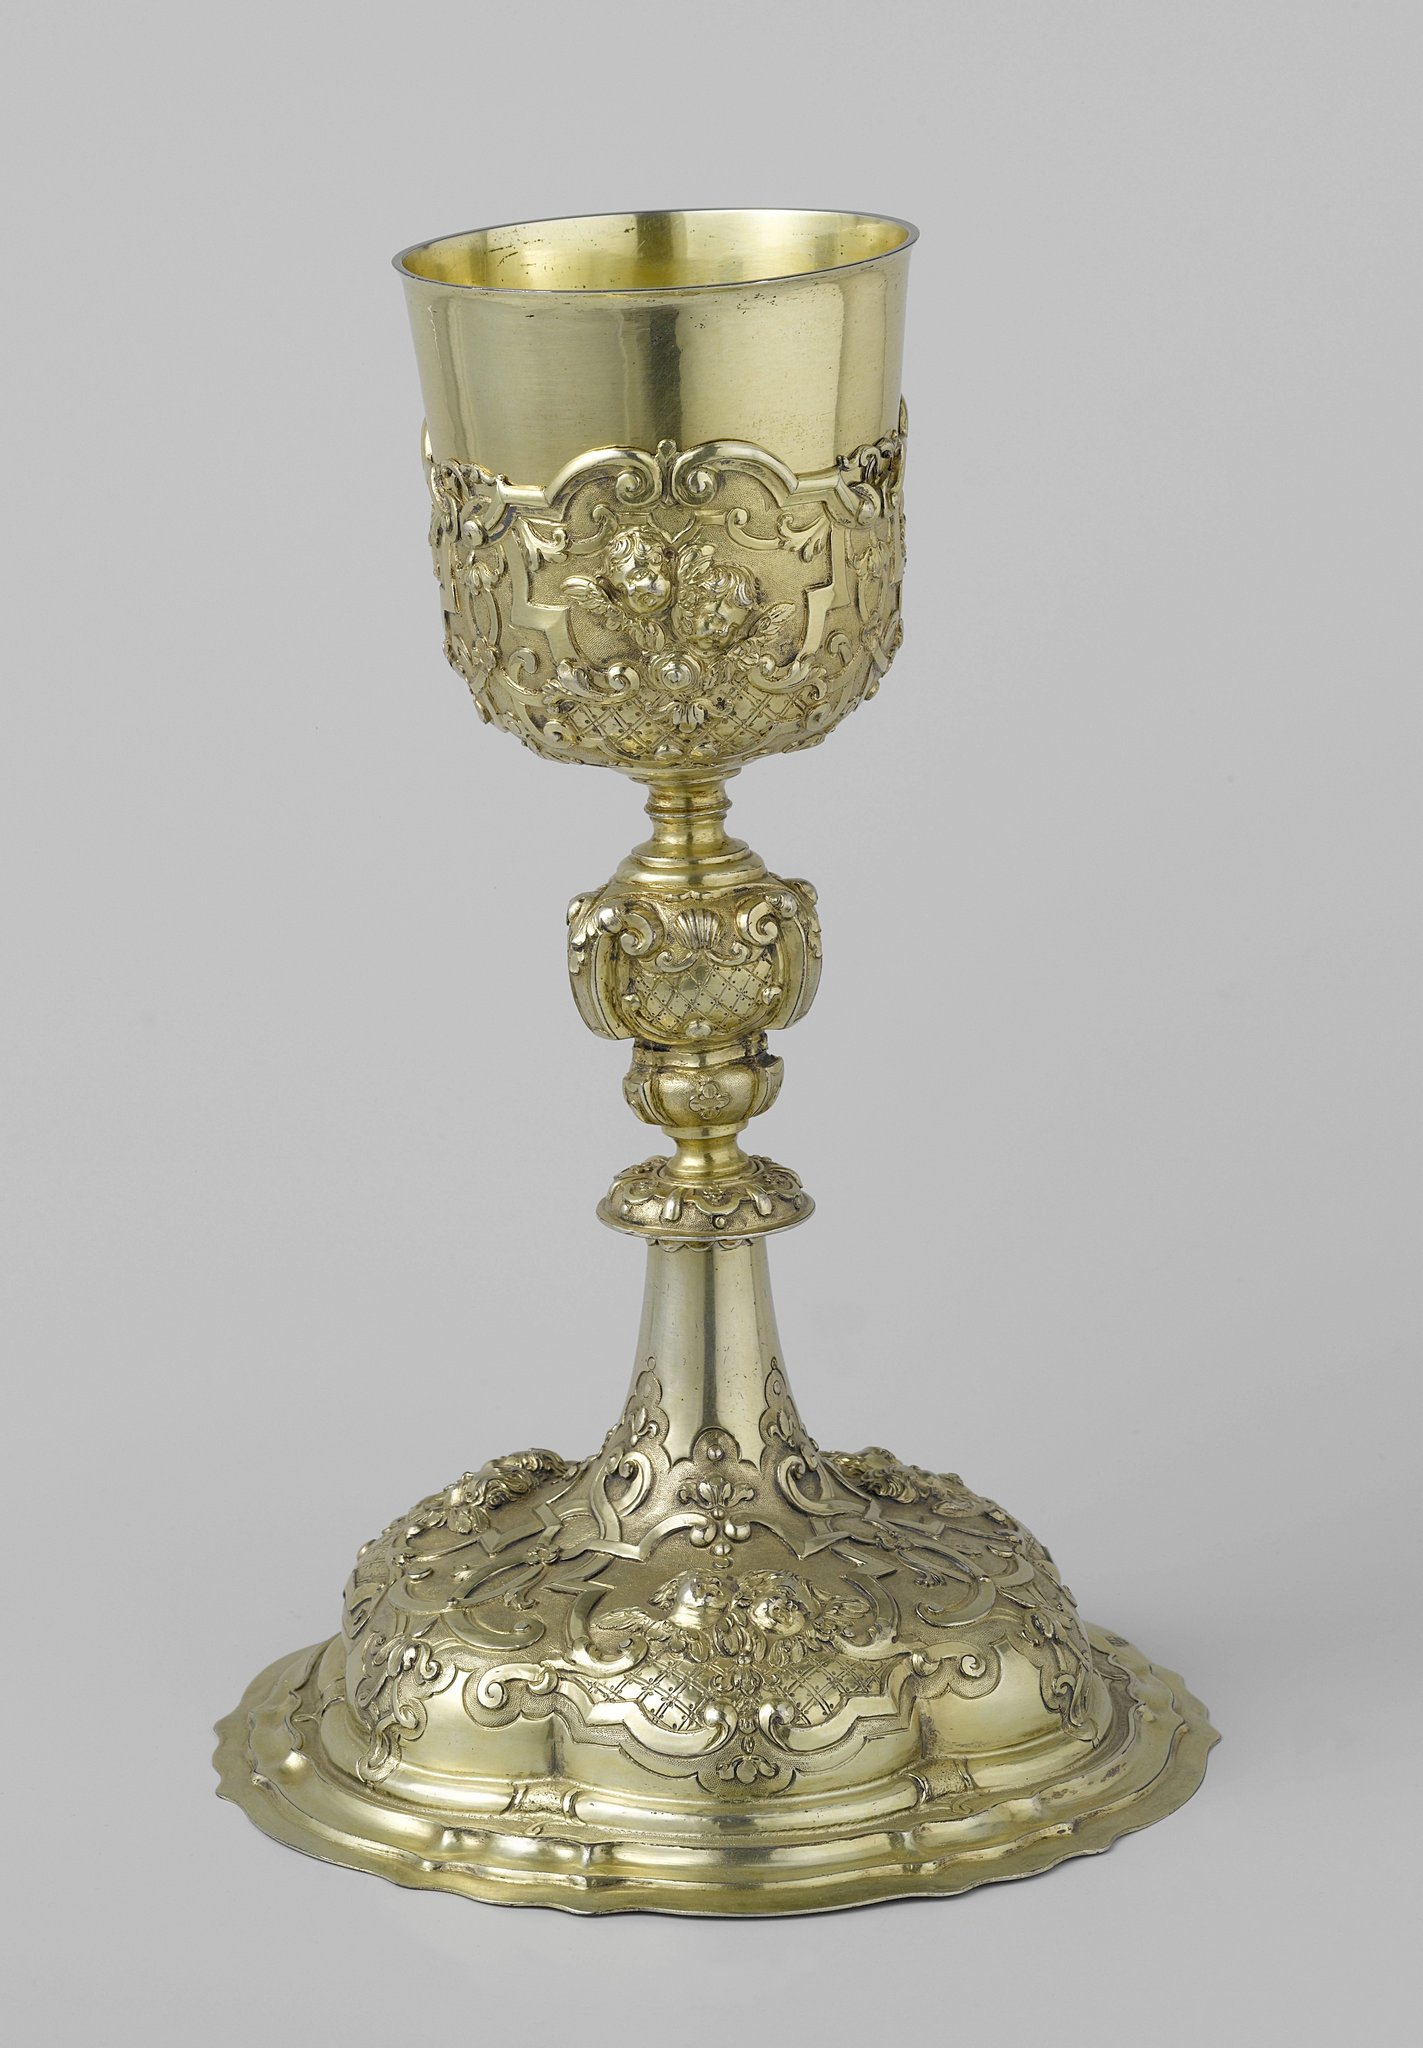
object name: chalice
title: Miskelk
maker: johann sebastian kipfinger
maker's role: silversmith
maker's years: 1671-1736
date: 1725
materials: silver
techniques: gilding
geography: freising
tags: cherubs, i.e. children's heads with wings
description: Chalice. Silver gilt. Freising (Bavaria), c. 1725, by Sebastian Kipfinger. Given by the Vereniging Rembrandt, 1897.